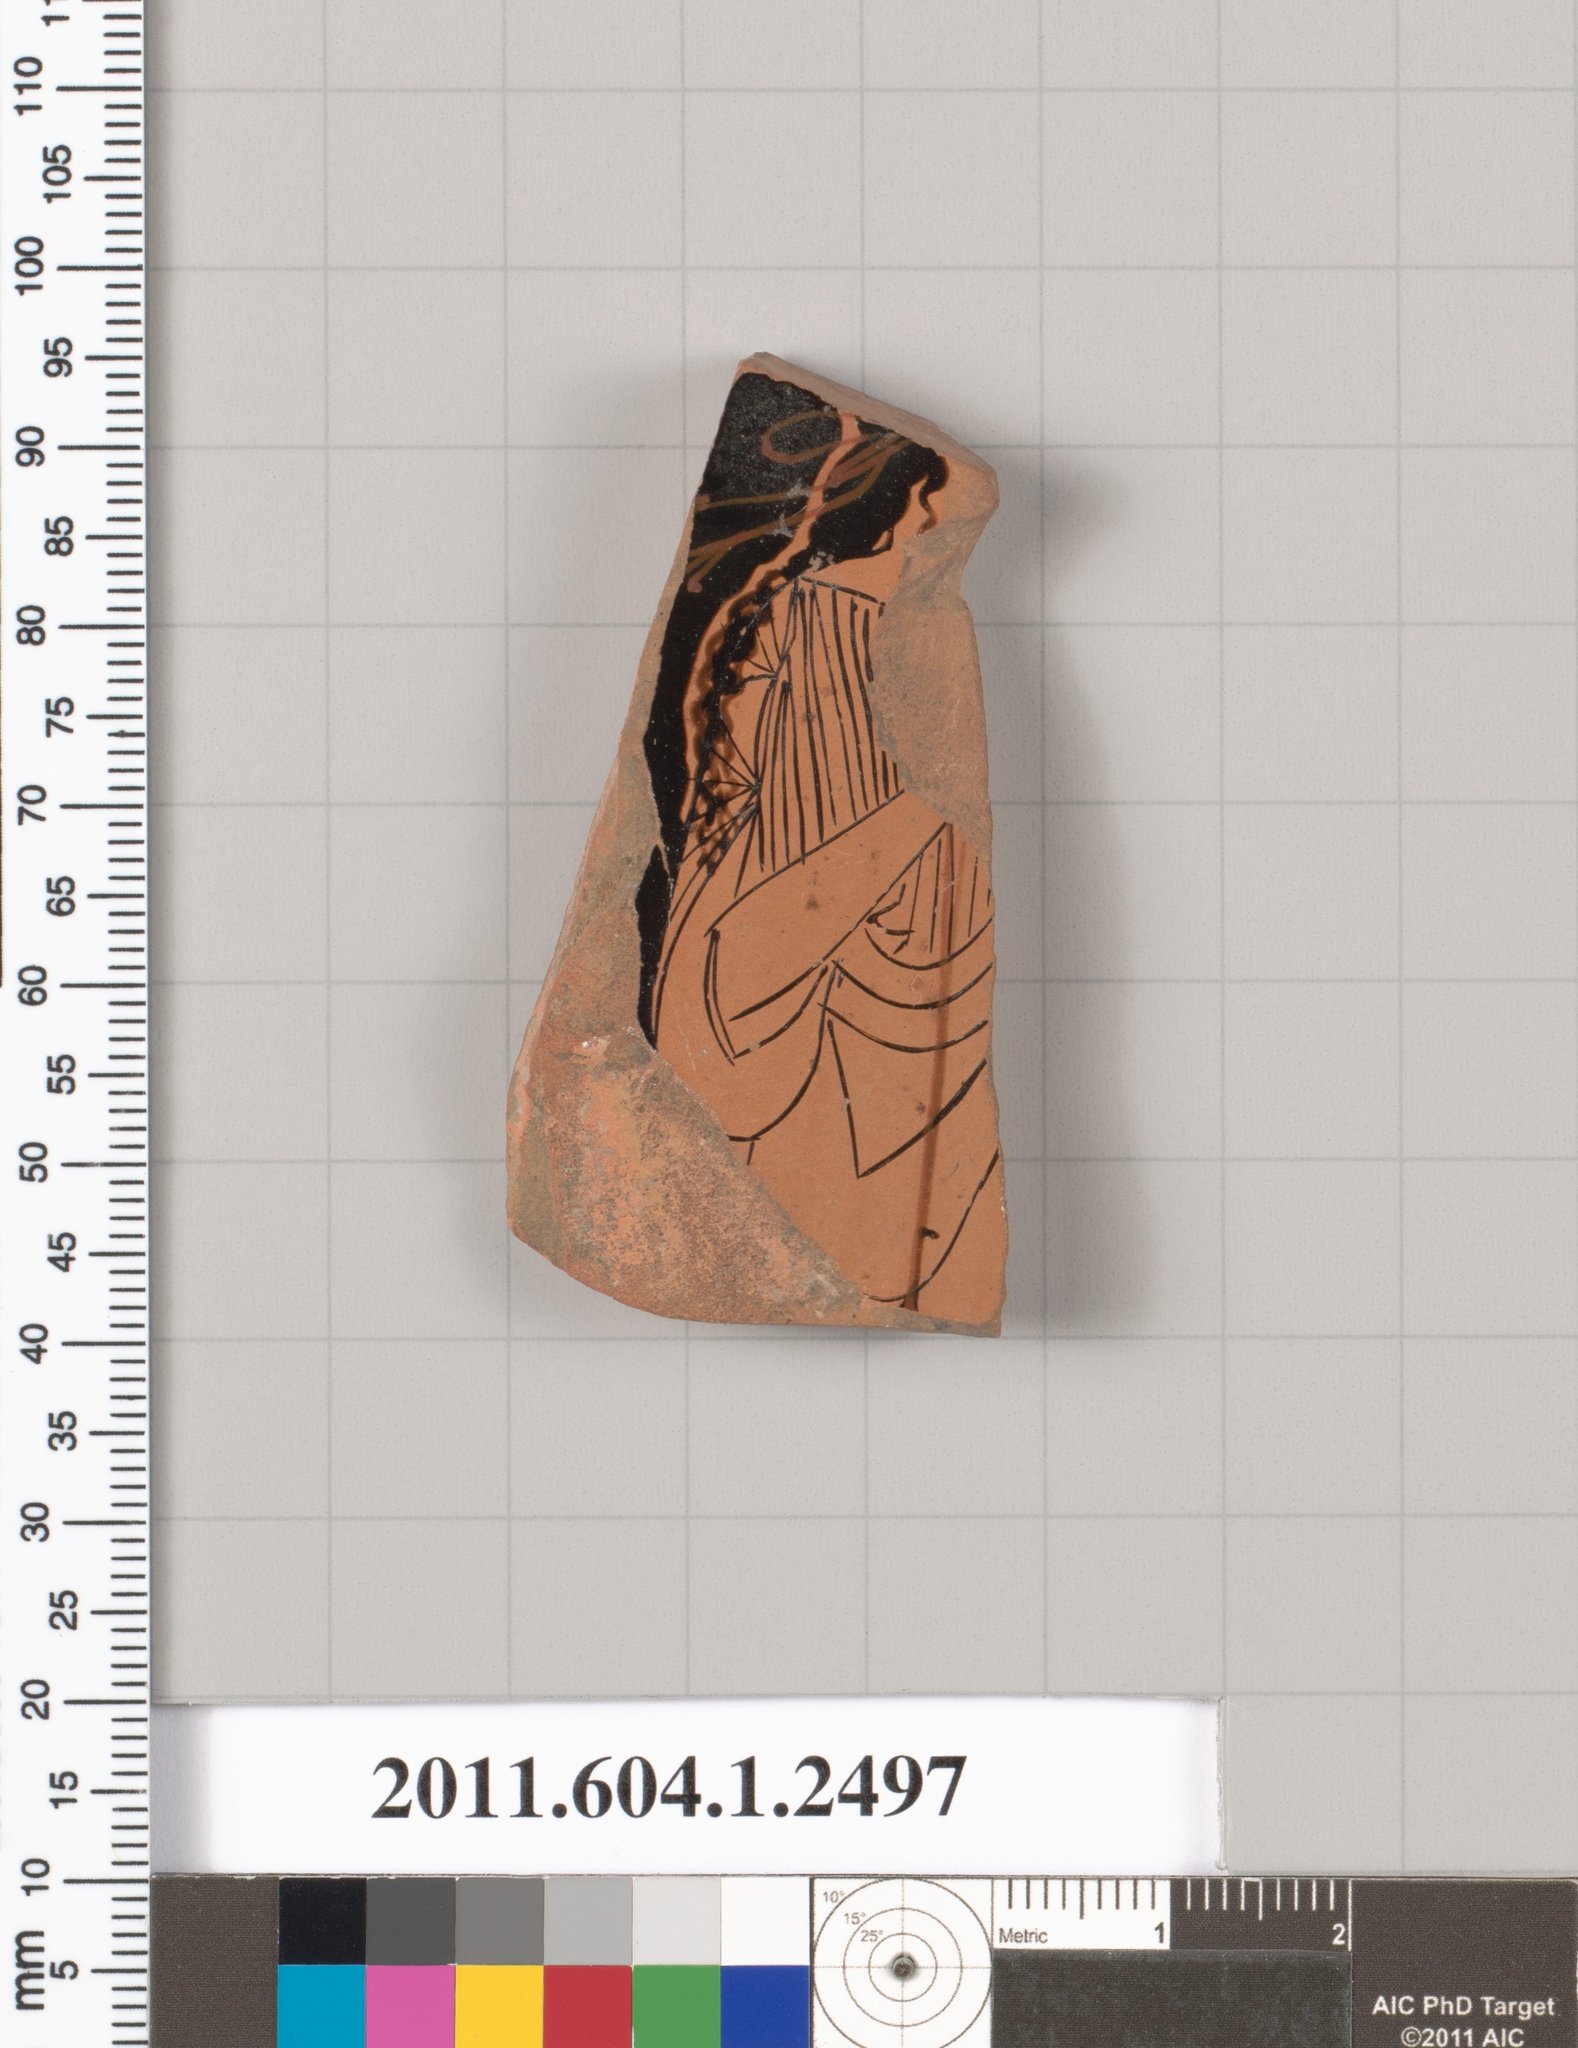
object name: kylix fragment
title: Terracotta fragment of a kylix (drinking cup)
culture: greek, attic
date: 490-480 BCE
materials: terracotta